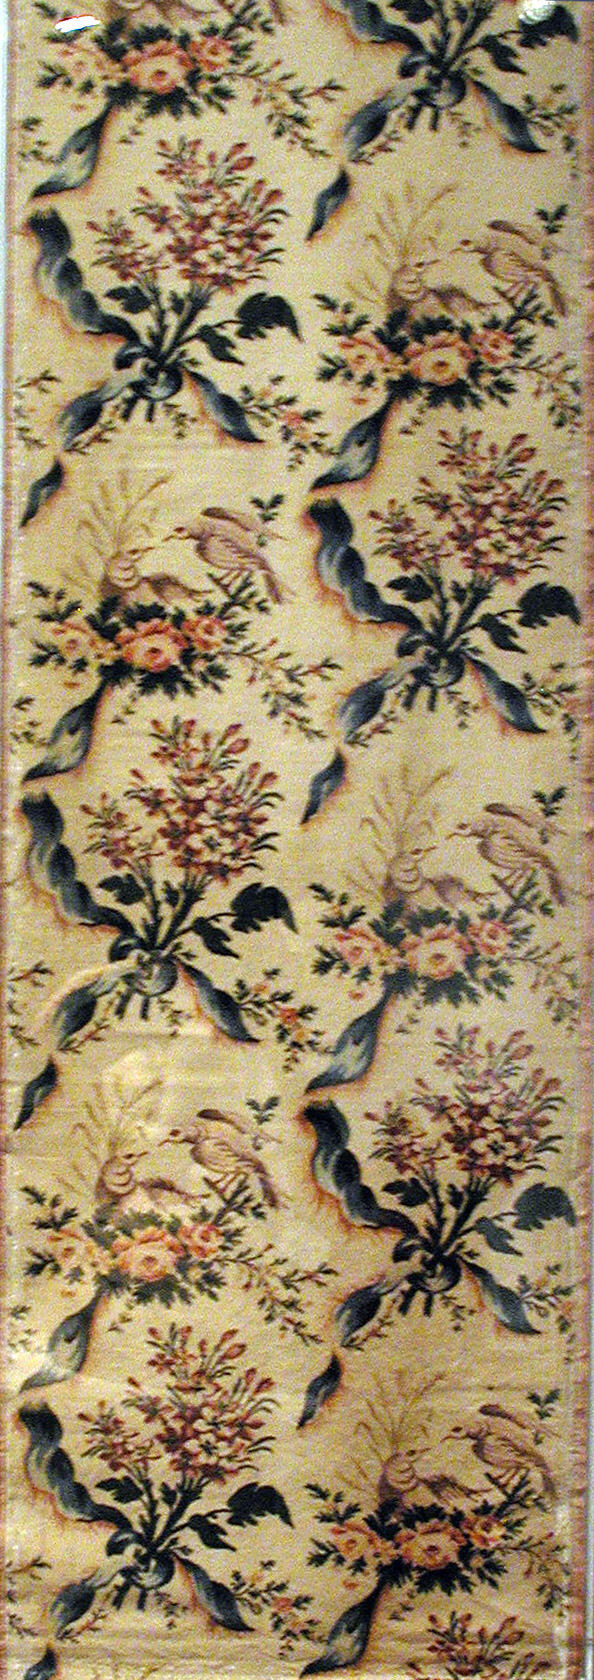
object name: length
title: Length of Chiné velvet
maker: maison pernon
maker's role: manufactory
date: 1788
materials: silk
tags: birds,flowers